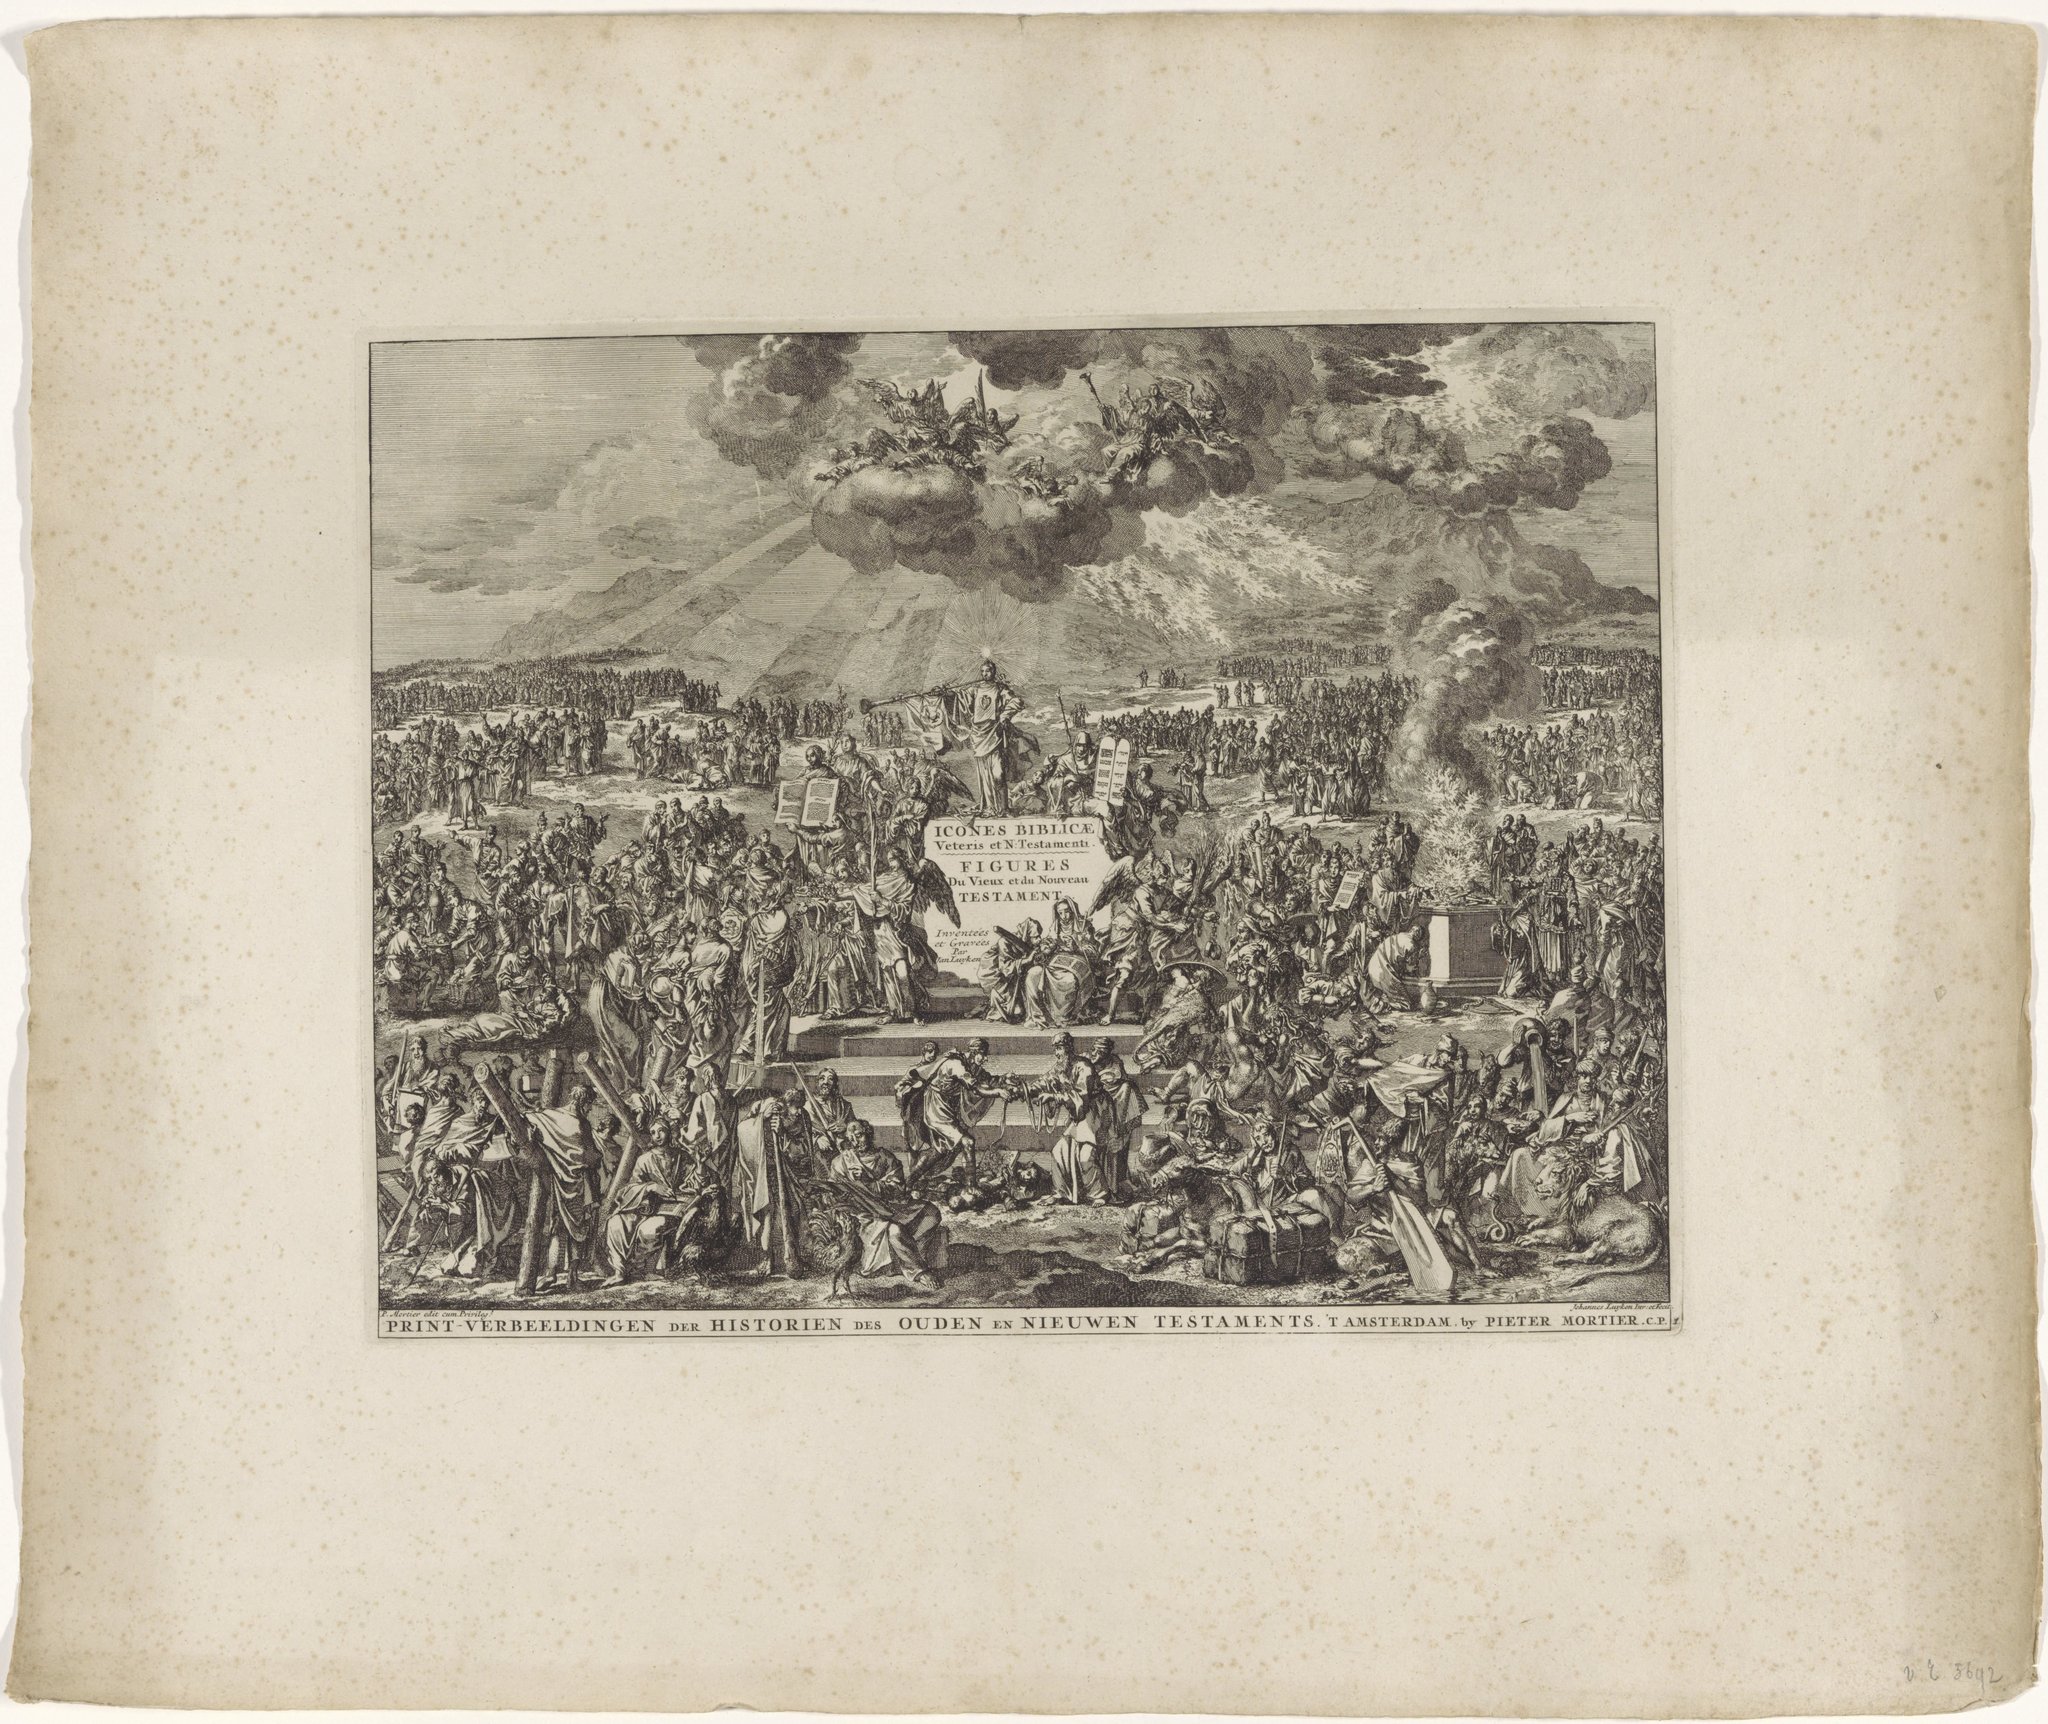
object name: titelblad, titelpagina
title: Icones Biblicae Veteris et N: Testamenti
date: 1708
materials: paper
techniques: etching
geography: amsterdam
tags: the twelve apostles ~ other themes, the ten commandments represented together on stone tablets, angels, works of mercilessness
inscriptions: collector's mark: Lugt 2228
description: Titelpagina voor 'Icones Biblicae Veteris et Novi Testamenti', 1708. In het midden blaast een engel op een bazuin, omringd door een mensenmassa. Rechts van de engel een vrouw met de stenen tafelen der wet. Iets lager rechts worden de personificaties van Nijd, Dronkenschap, Gulzigheid, Gierigheid, Geveinstheid en Geweld door engelen bestreden. Links van de engel de zeven werken van barmhartigheid. Op de voorgrond de apostelen met hun attributen.